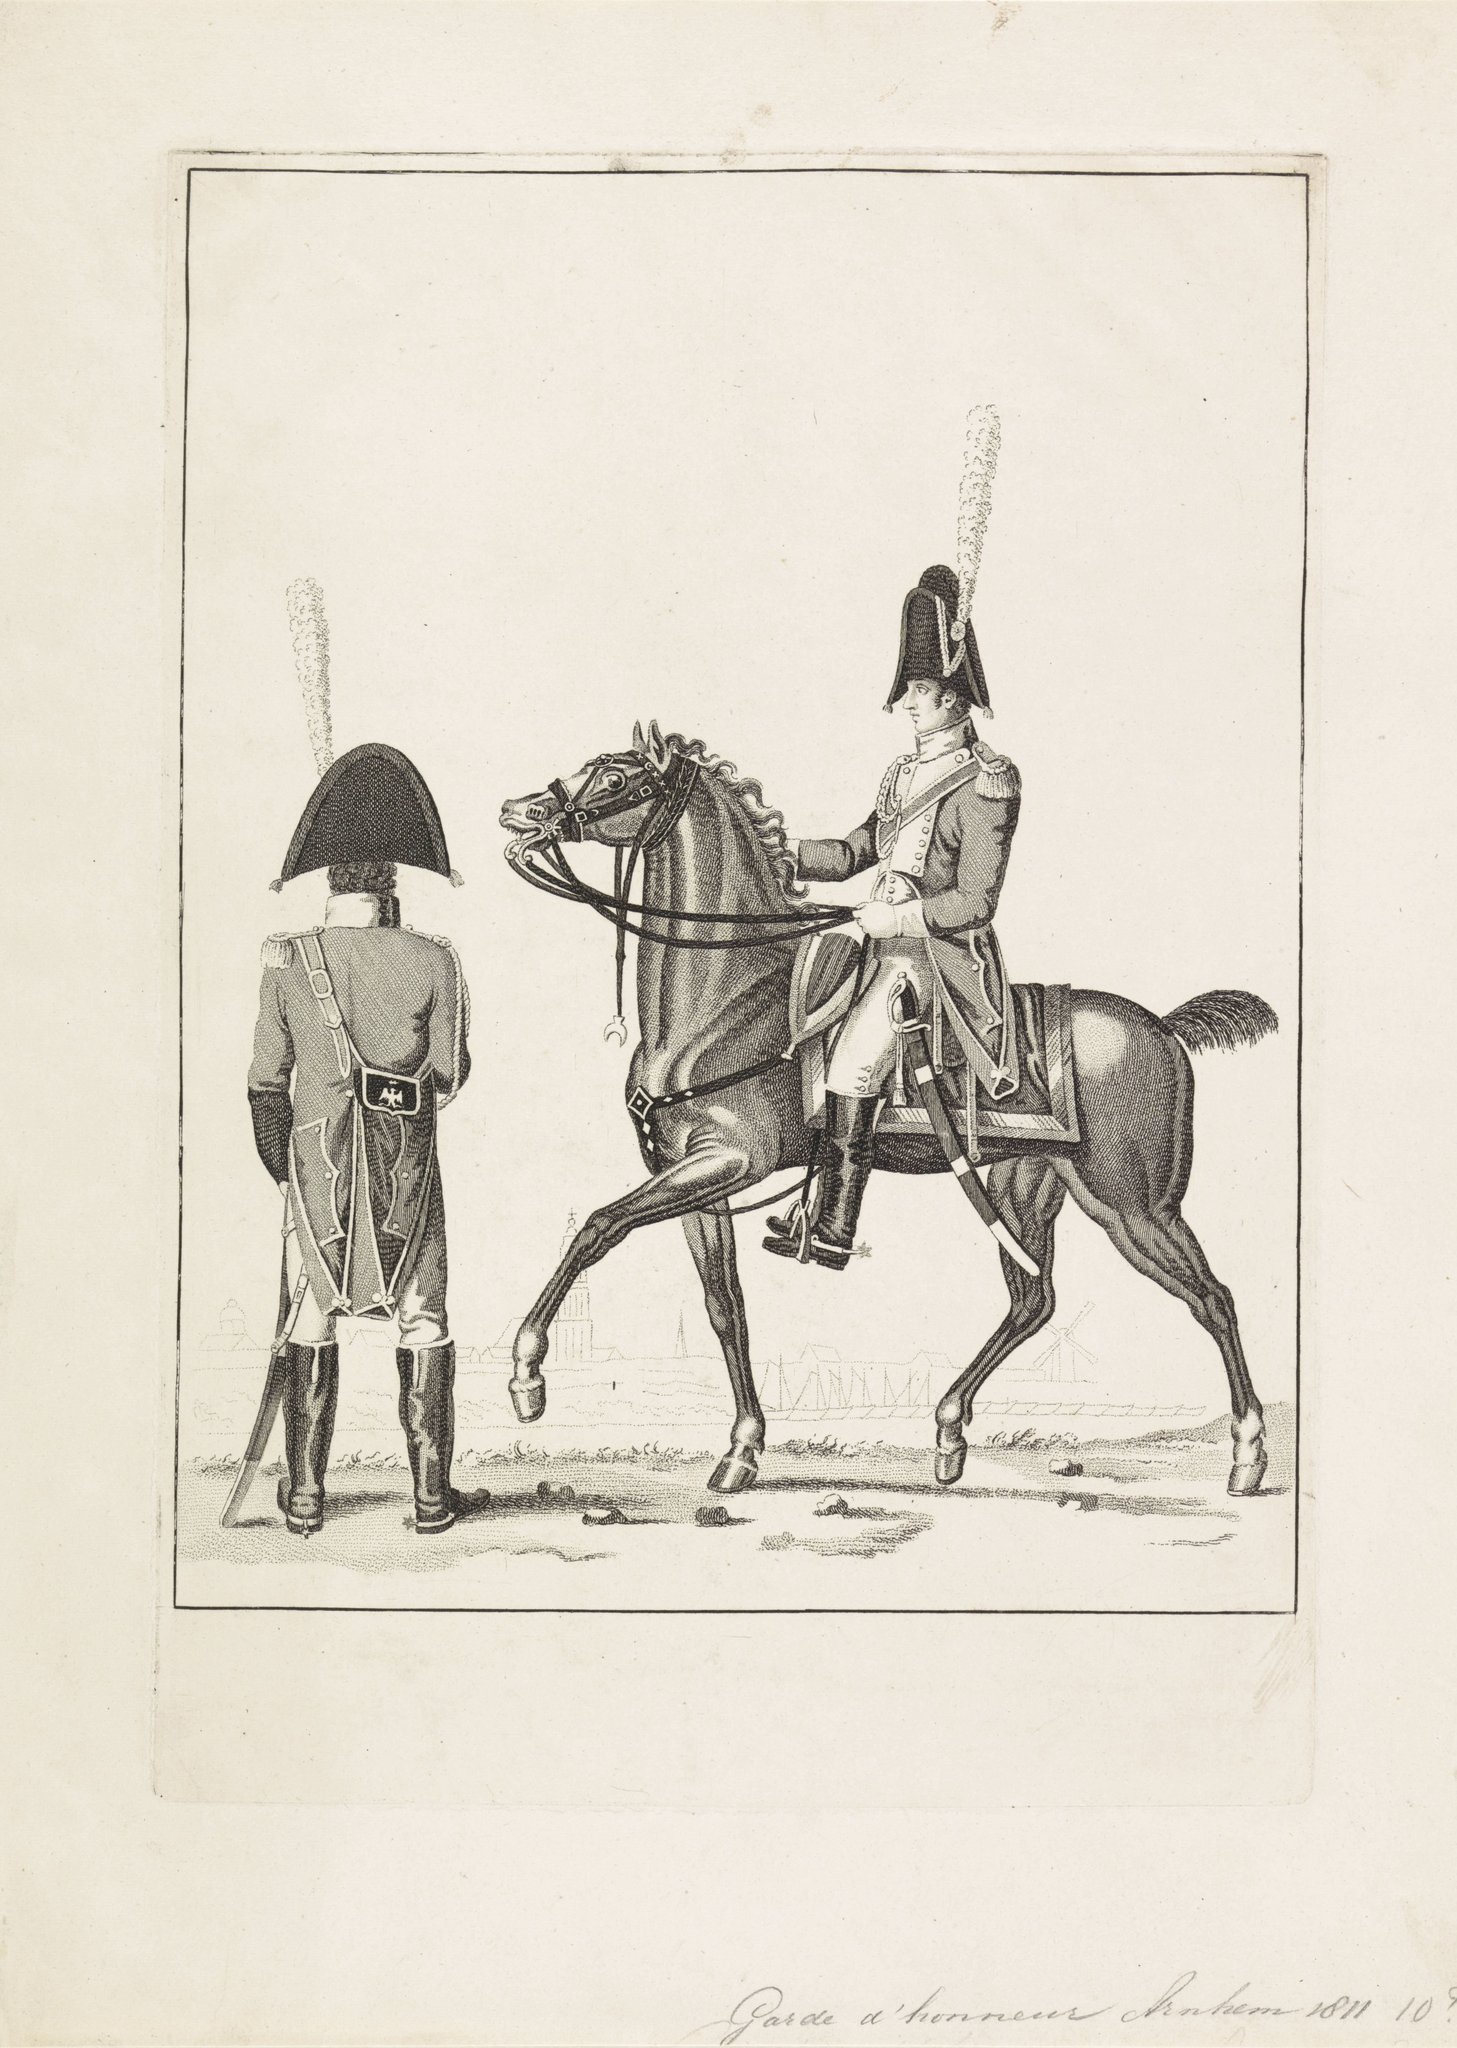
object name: print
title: Erewacht te Arnhem, 1811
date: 1811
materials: paper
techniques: etching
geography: amsterdam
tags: napoleon i (emperor of the french), guard of honour, (military) uniforms, arnhem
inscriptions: collector's mark: Lugt 2228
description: Twee leden van de cavalerie van de erewacht te Arnhem. Proefdruk voor het plaatwerk met twaalf platen van de verschillende uniformen van de erewachten in de zeven Nederlandse departementen, opgericht voor het bezoek van Napoleon Bonaparte aan Nederland in 1811. Met afwijkende hoofddeksels, zonder de titel maar met het profiel van de stad.